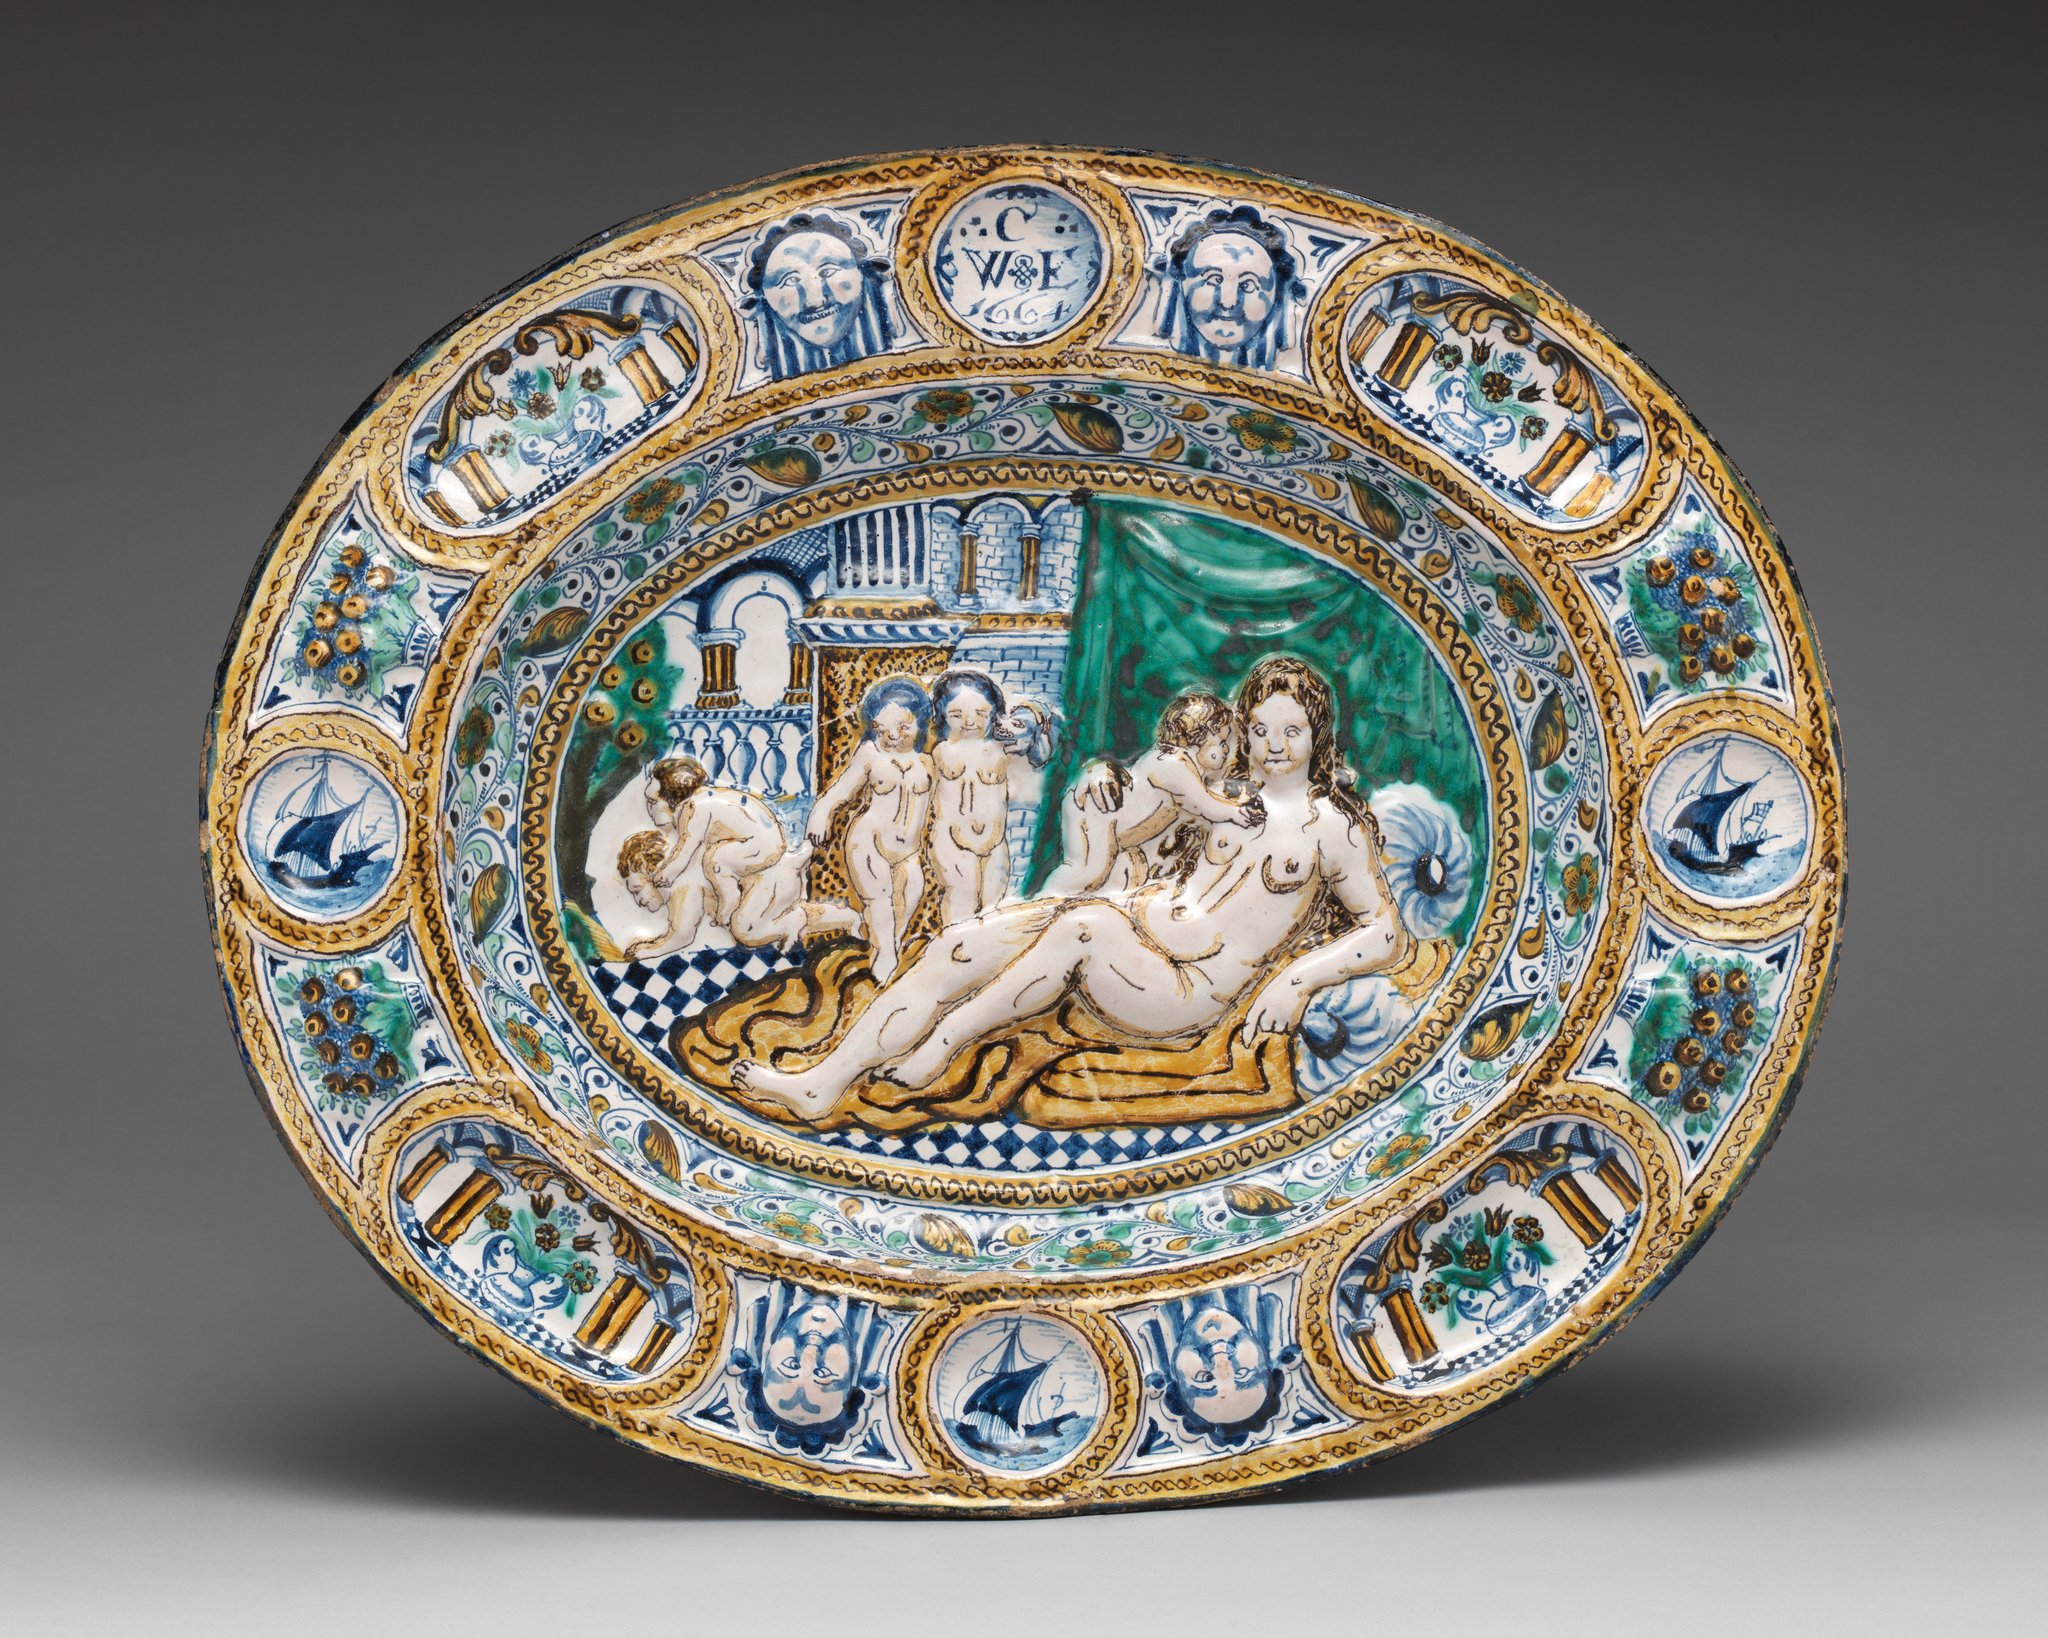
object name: dish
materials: earthenware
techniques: glazing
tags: female nudes